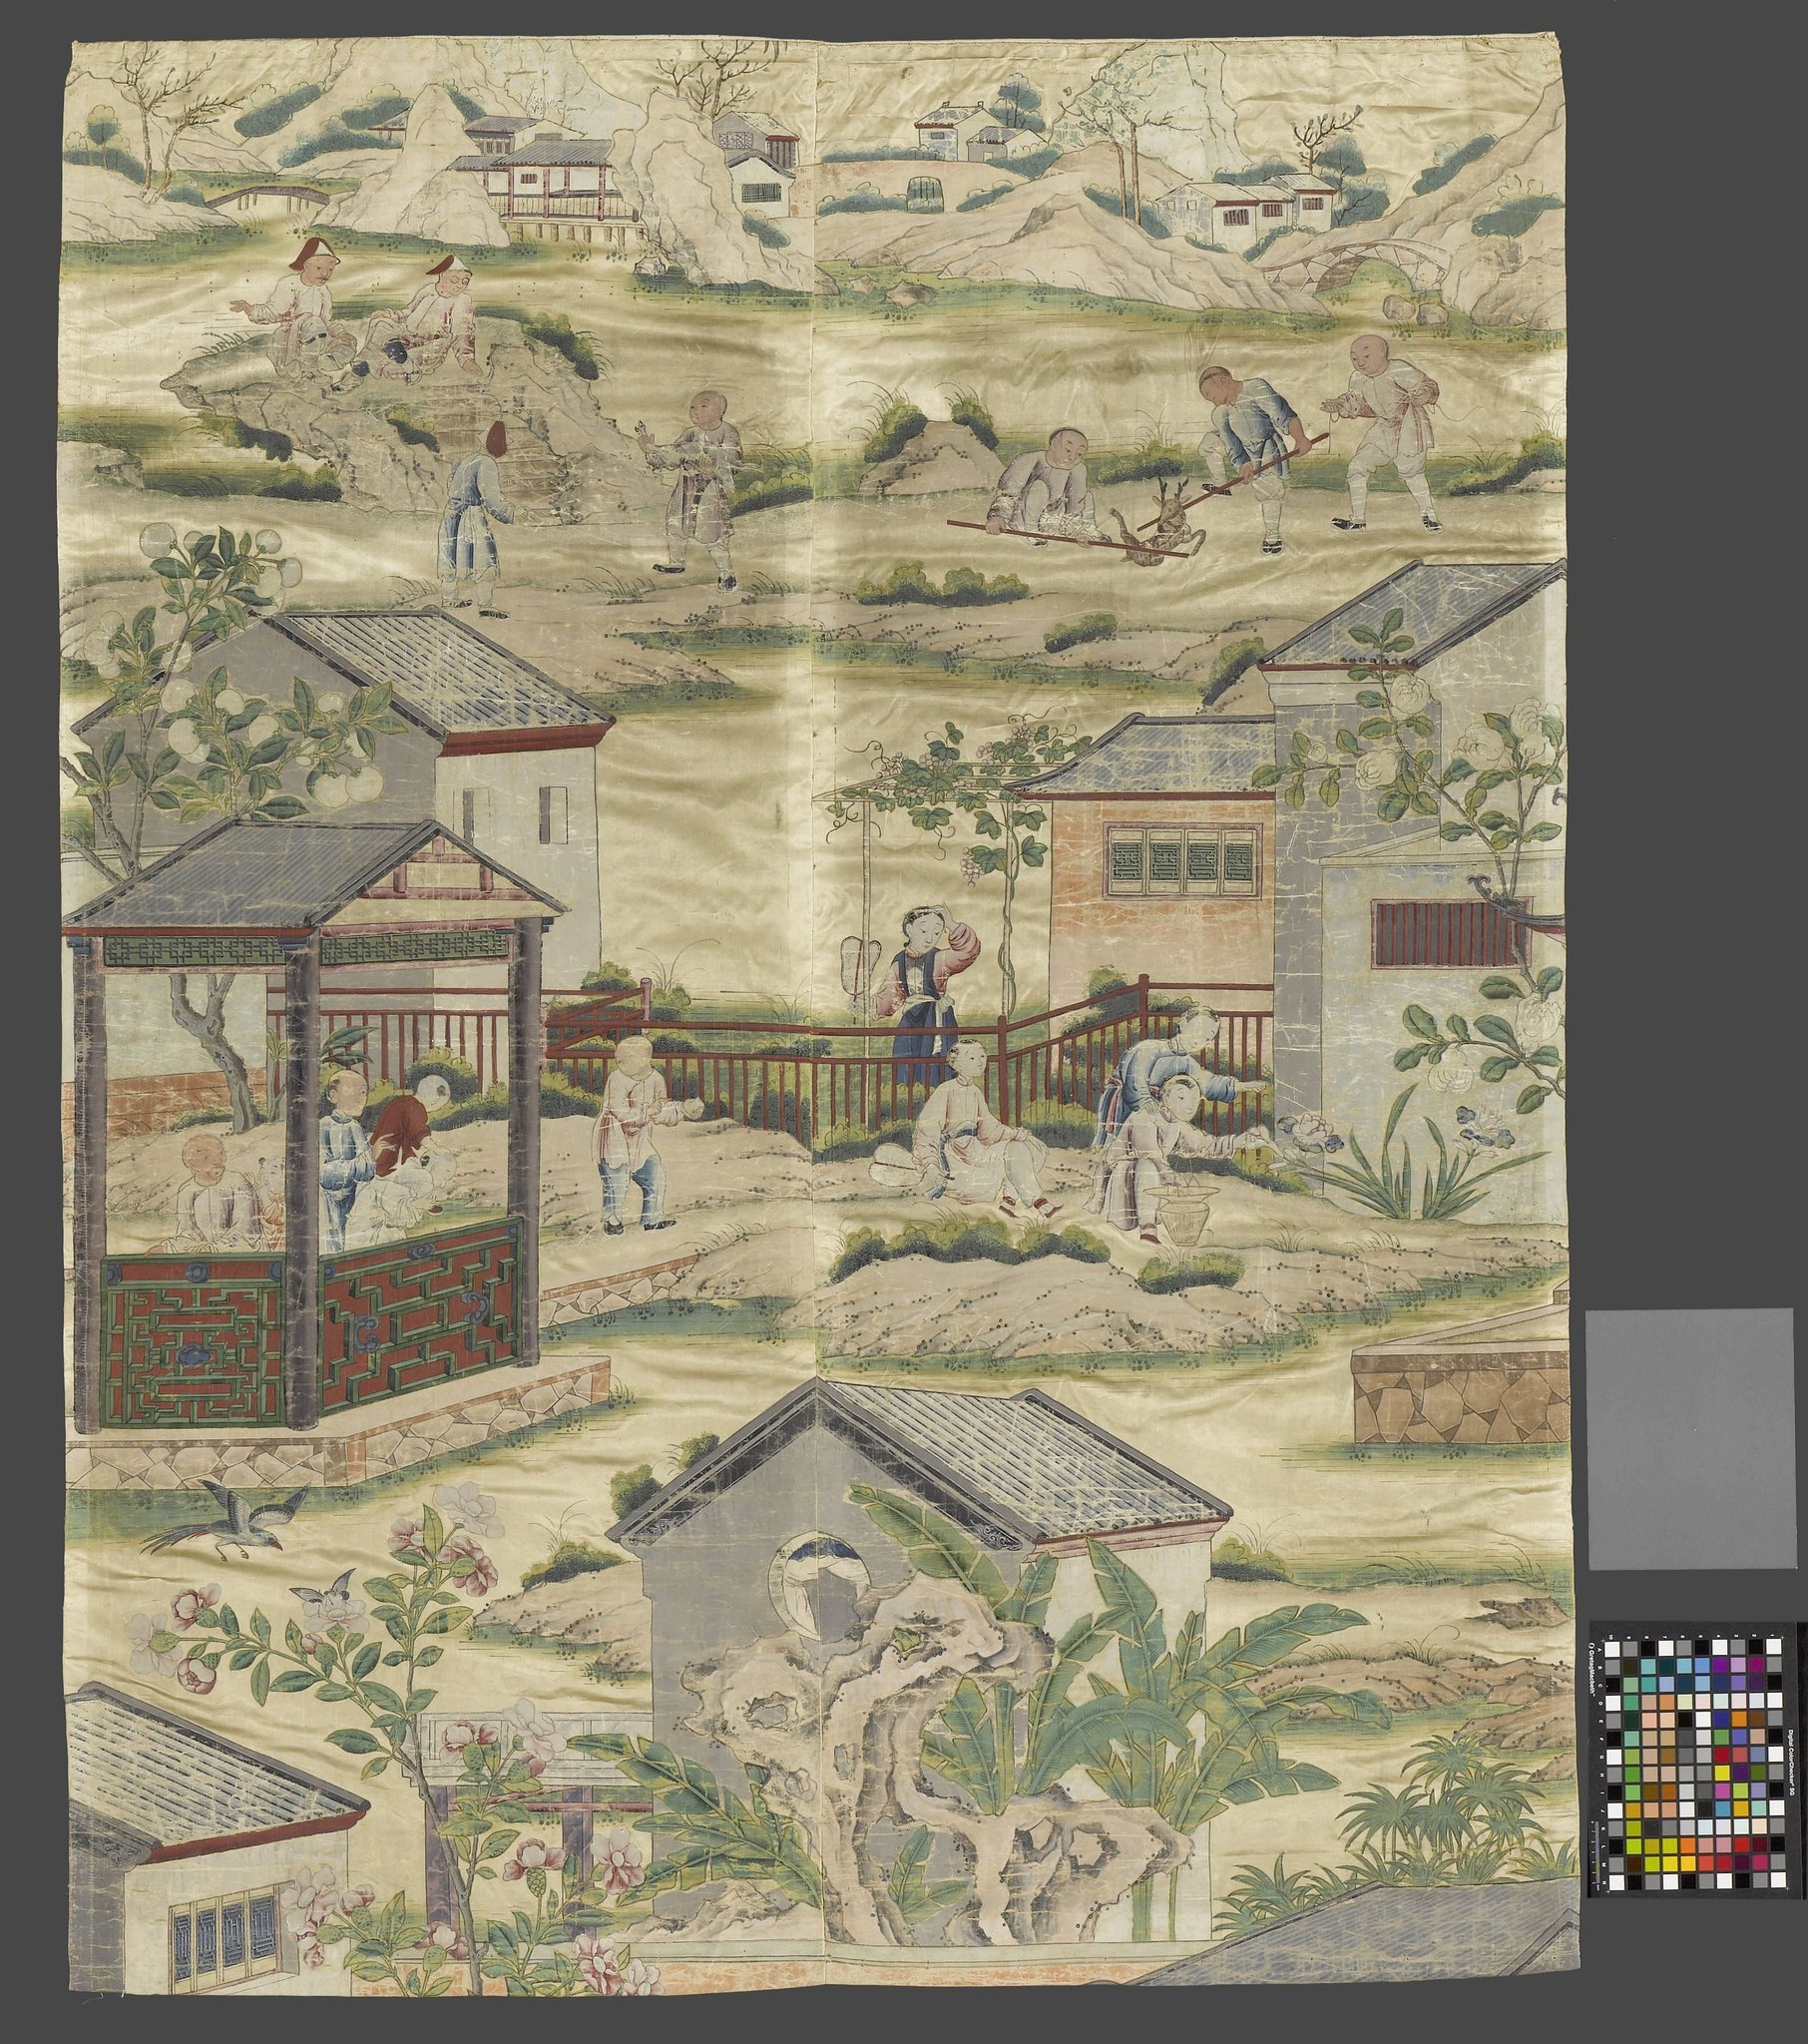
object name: upholstered wall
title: Fragment van een wandbespanning met Chinese genre-taferelen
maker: Anonymous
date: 1775-1790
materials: textile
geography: china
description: Fragment van een wandbespanning met Chinese genre-taferelen. Voorgrond ontbreekt. Middenplan met huis bij rotspunt en palmbomen. Daarachter terrassen met paviljoens door rood hek gescheiden. Links oude mannen met kinderen op de schouder. Rechts drie vrouwen, bloemen plukkende. Op een landschaps achtergrond zijn boven aan een trap twee voorname heren gezeten, waavan één met bril, terwijl een man een kalfje aandraagt. Rechts wordt door drie mannen een hert gevangen. In het verschiet bergtoppen en huizen.